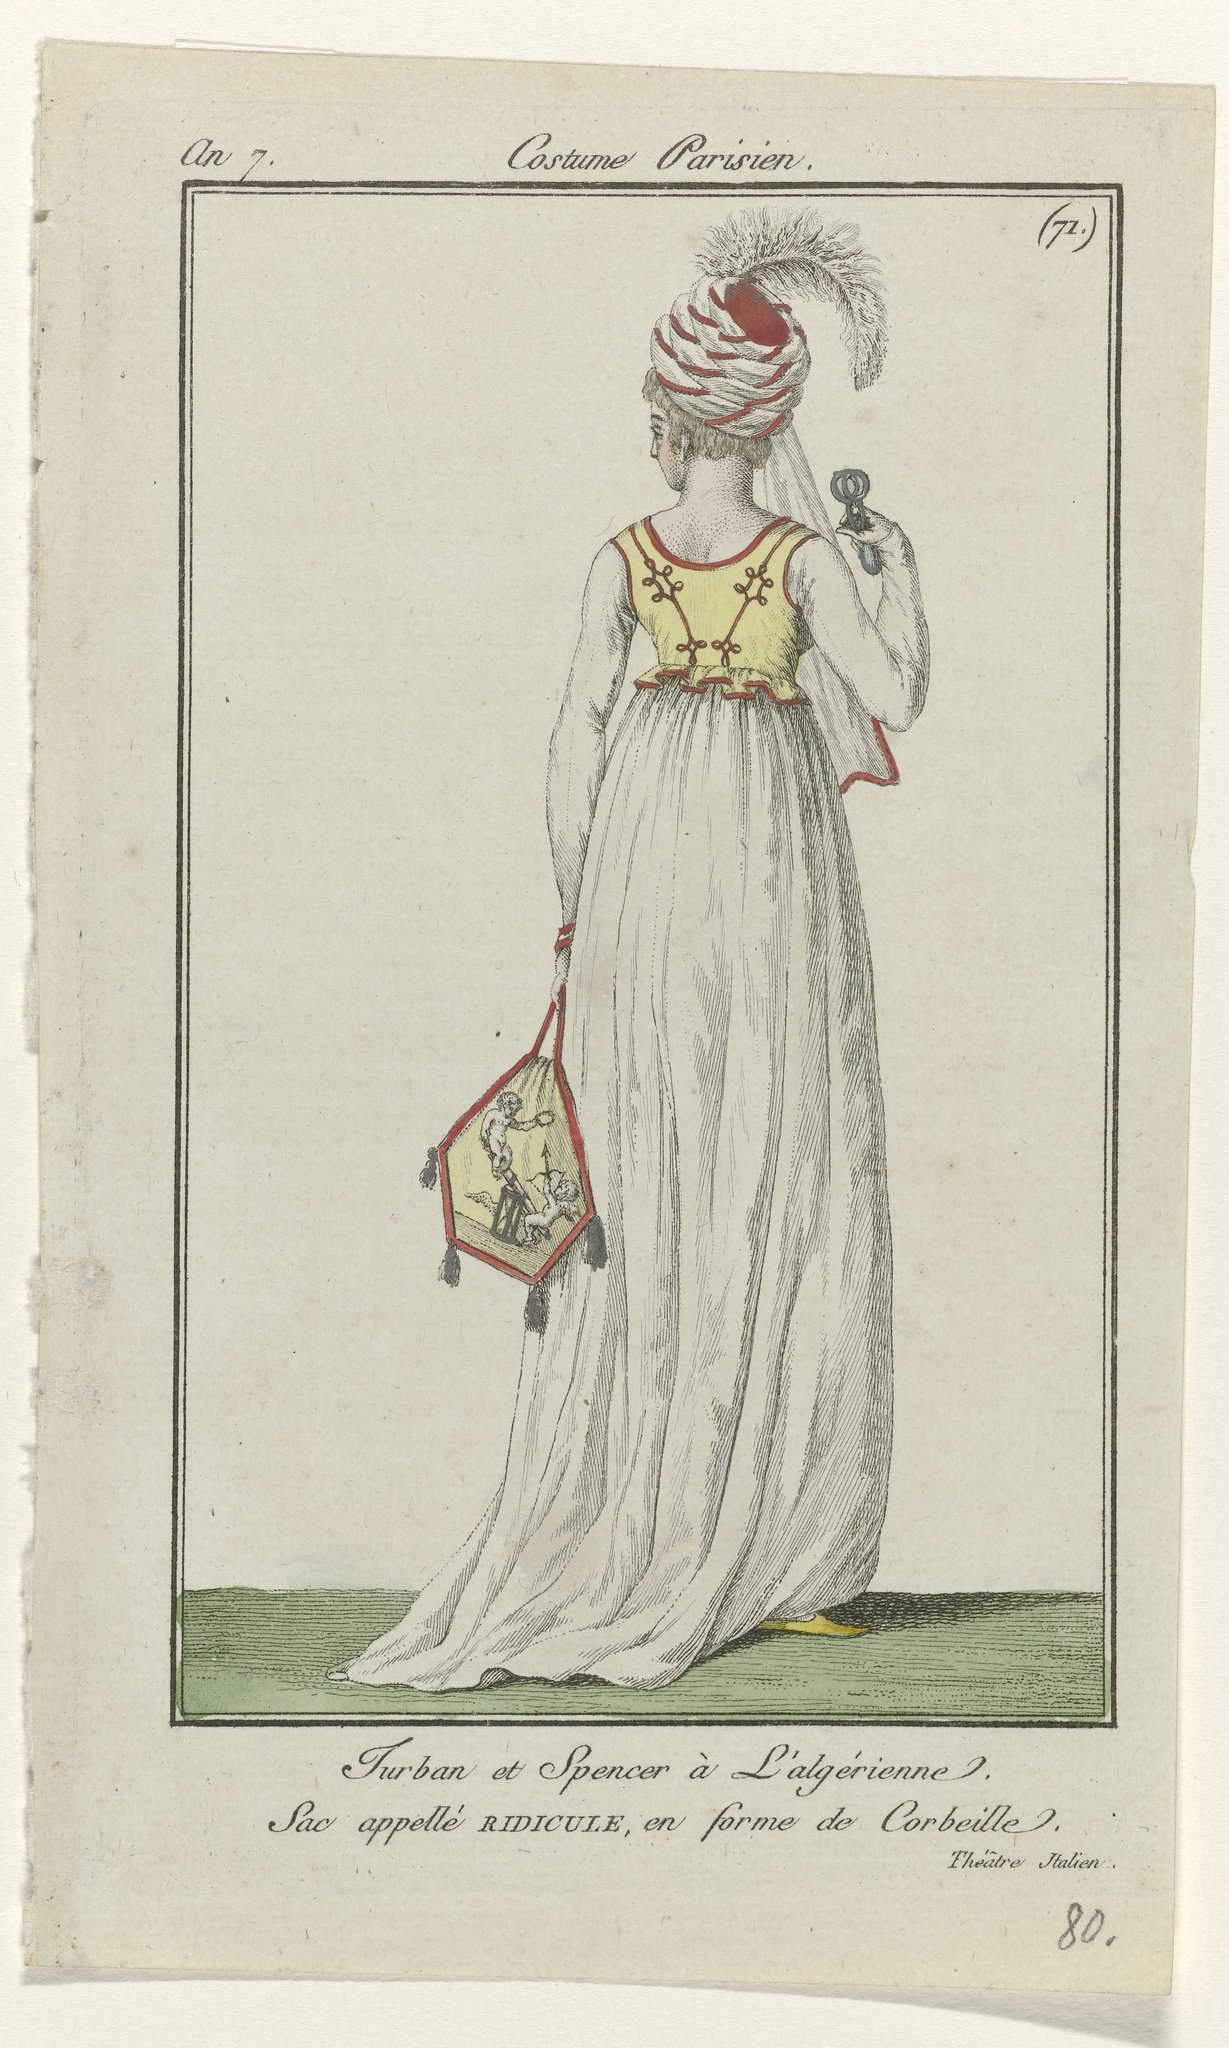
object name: fashion print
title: Journal des Dames et des Modes: Ladies’ Fashion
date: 1798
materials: paper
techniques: engraving, hand coloring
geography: paris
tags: head-gear: turban (+ women's clothes), bag (reticule) (+ women's clothes), eyeglasses, spectacles (+ female (human being) (not to be used where -aa- is prescribed)), clothing for the upper part of the body (spencer) (+ women's clothes), fashion plates, shoes, sandals (+ women's clothes), dress, gown (+ women's clothes)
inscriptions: caption: ‘Turban et Spencer à l'Algérienne. Sac appellé Ridicule, en forme de Corbeille. / Théâtre Italien.’, title: ‘Costume Parisien.’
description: After the turbulent years of the French Revolution, in 1797 a fashion magazine was finally published again: the Journal des Dames et des Modes. Under the direction of Pierre de La Mésangère, it developed a cosmopolitan flair. The very best draughtsmen were recruited to produce the fashion illustrations, called Costumes Parisiens. They visited spots all over Paris to ensure they saw the latest styles. These included high-waisted gowns with low necklines, ‘Greek’ slippers with cross-laces 1, genuine Kashmiri shawls 2, reticules 3 (small stylish handbags), poke bonnets 4 and full-length English coats knowns as redingotes 5.